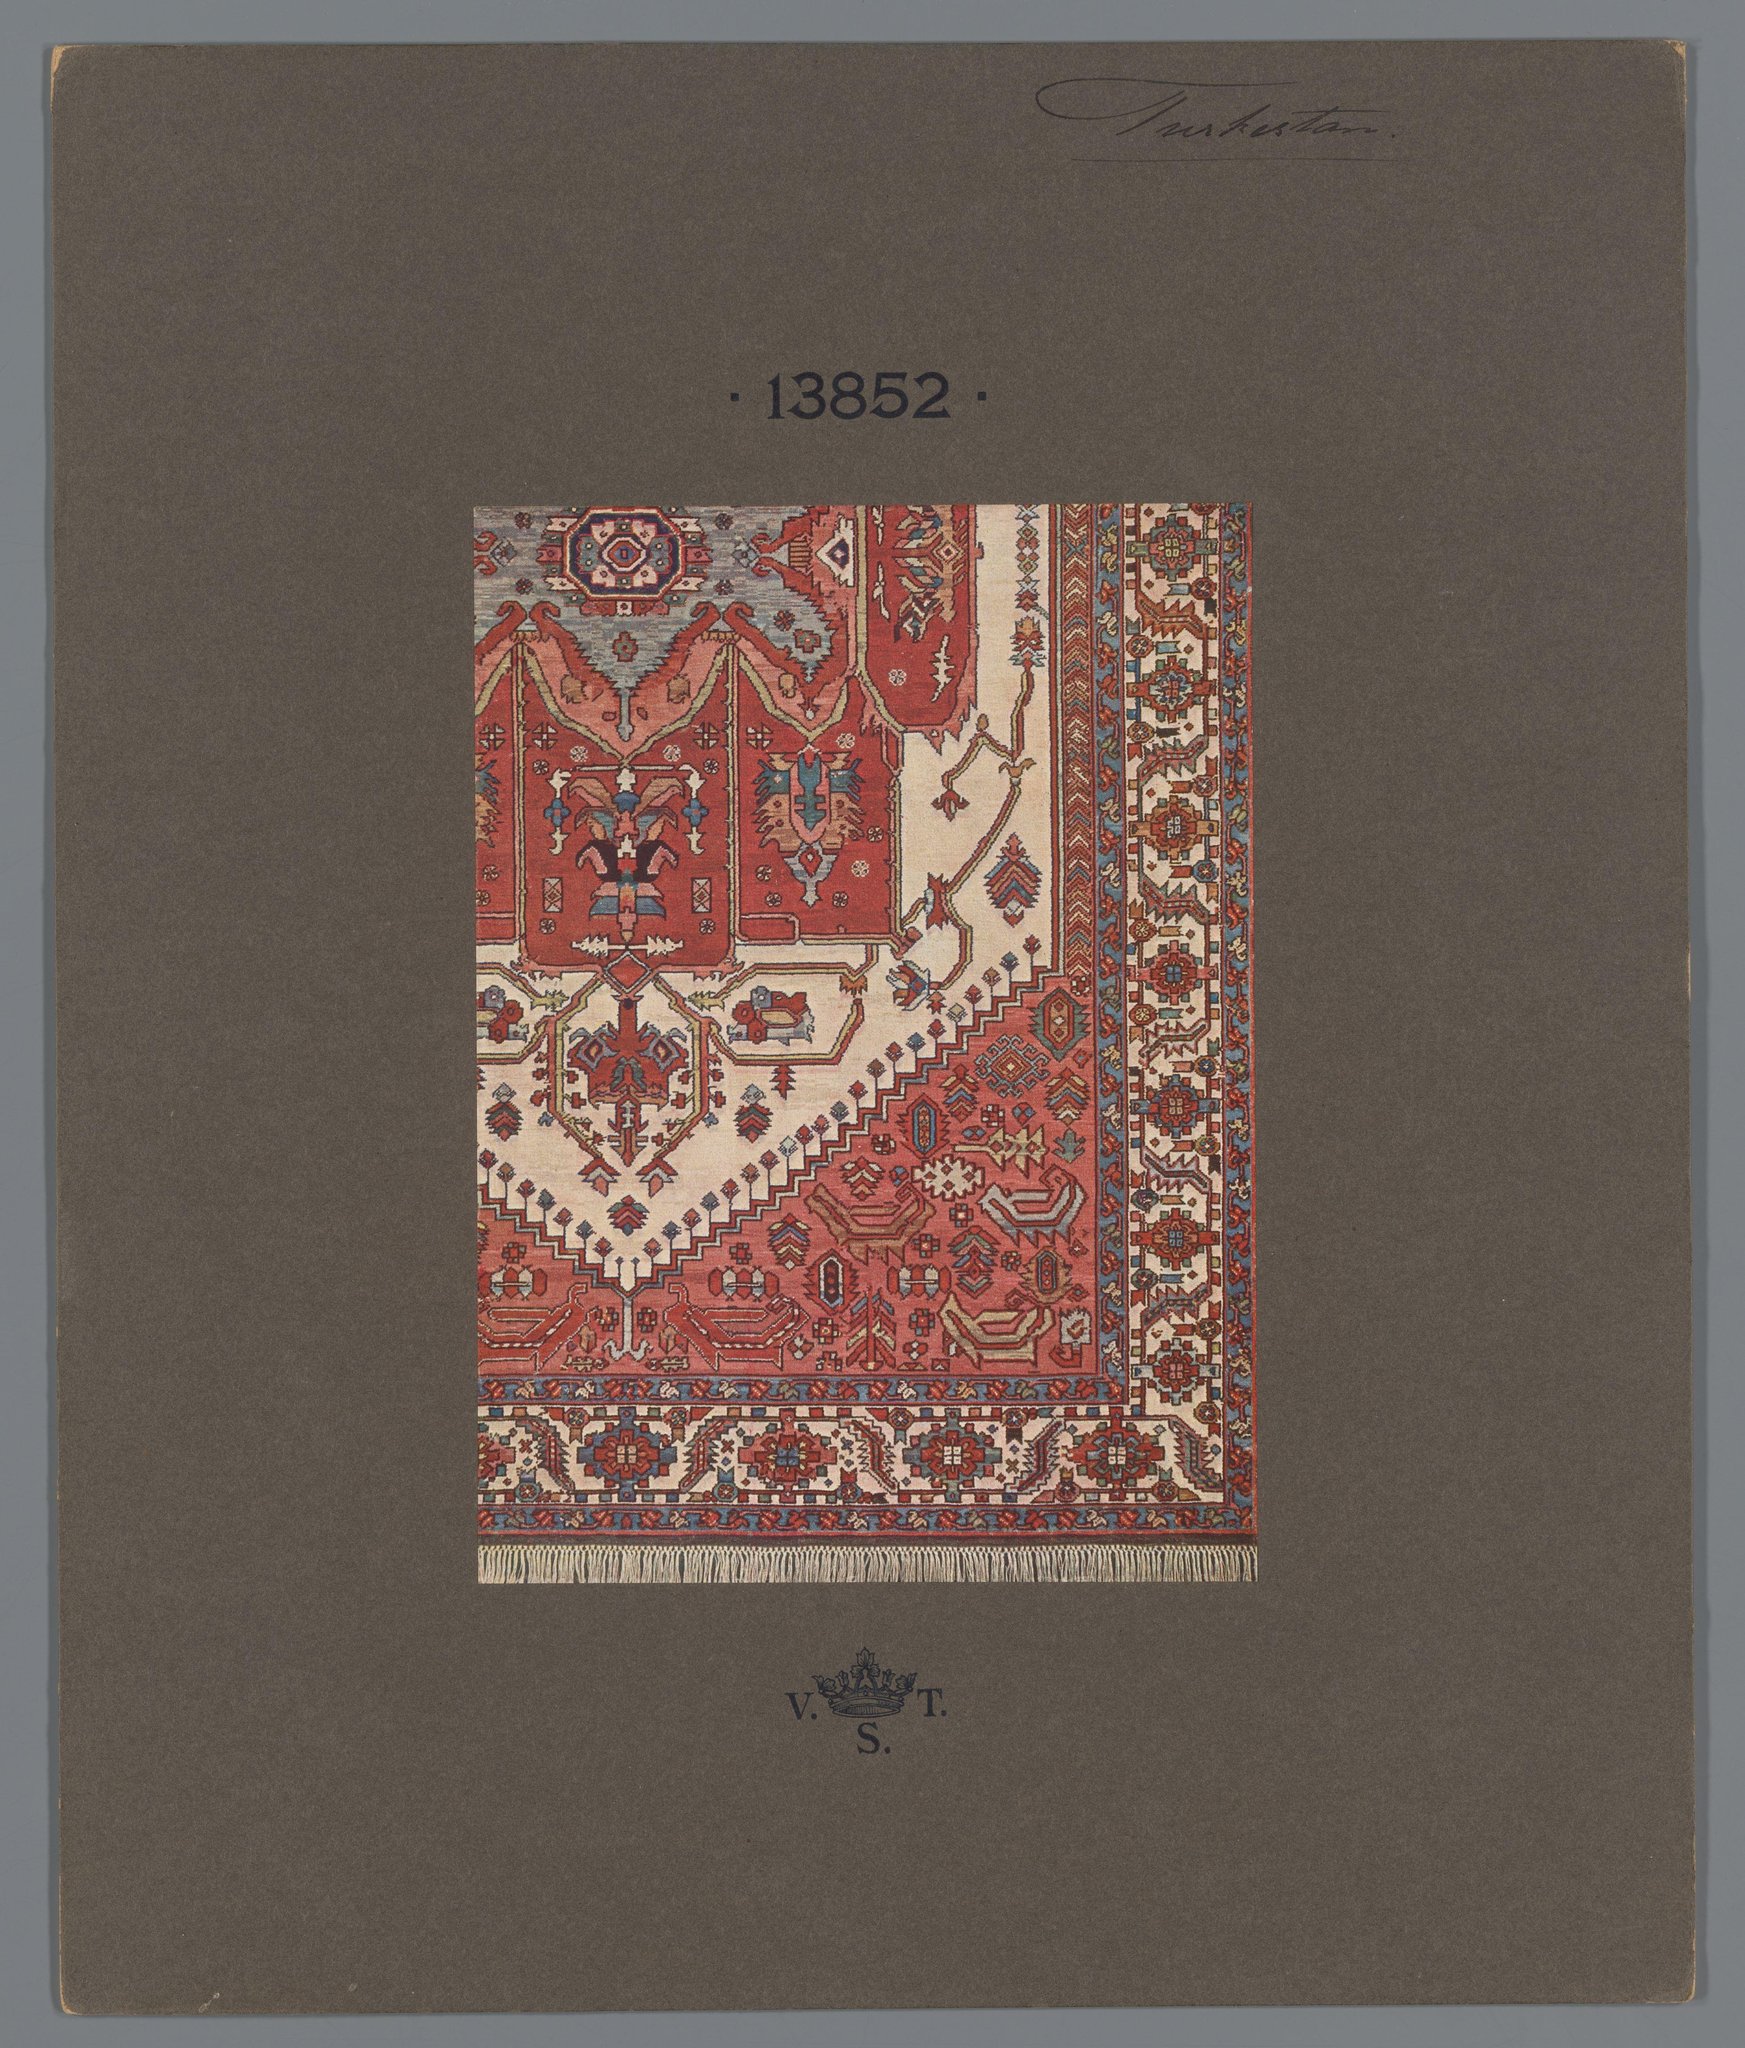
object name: photomechanical print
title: Deel van een tapijt met bloemenpatroon en fantasieornamenten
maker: Anonymous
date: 1907-1929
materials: cardboard, paper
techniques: autotype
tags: fantasy ornament, carpet, rug, flowers ~ ornament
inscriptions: number: ‘.13852.’, annotation: ‘Turkestan’, annotation: ‘Turkestan’, mark: ‘V.T.S.’